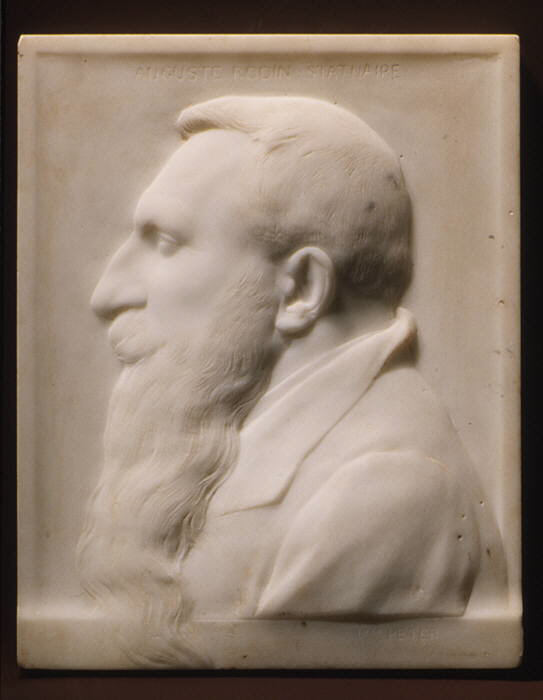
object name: relief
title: Portrait of Auguste Rodin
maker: victor peter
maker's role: artist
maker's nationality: french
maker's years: 1840-1918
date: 1900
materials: marble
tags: men,profiles